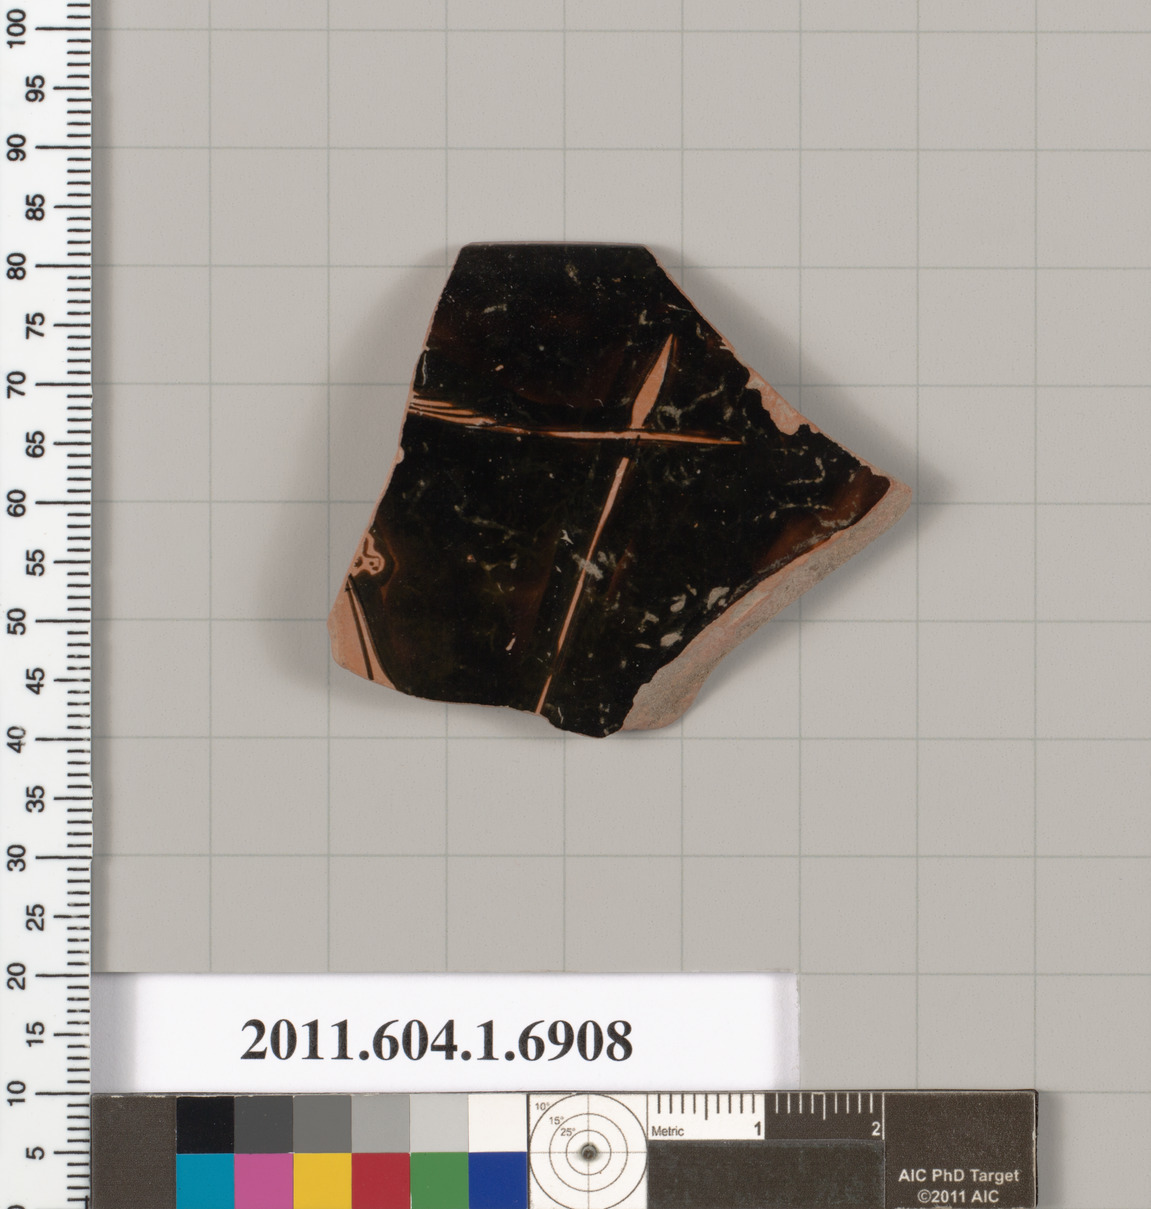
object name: kylix fragment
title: Terracotta rim fragment of a kylix (drinking cup)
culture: greek, attic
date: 490-470 BCE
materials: terracotta